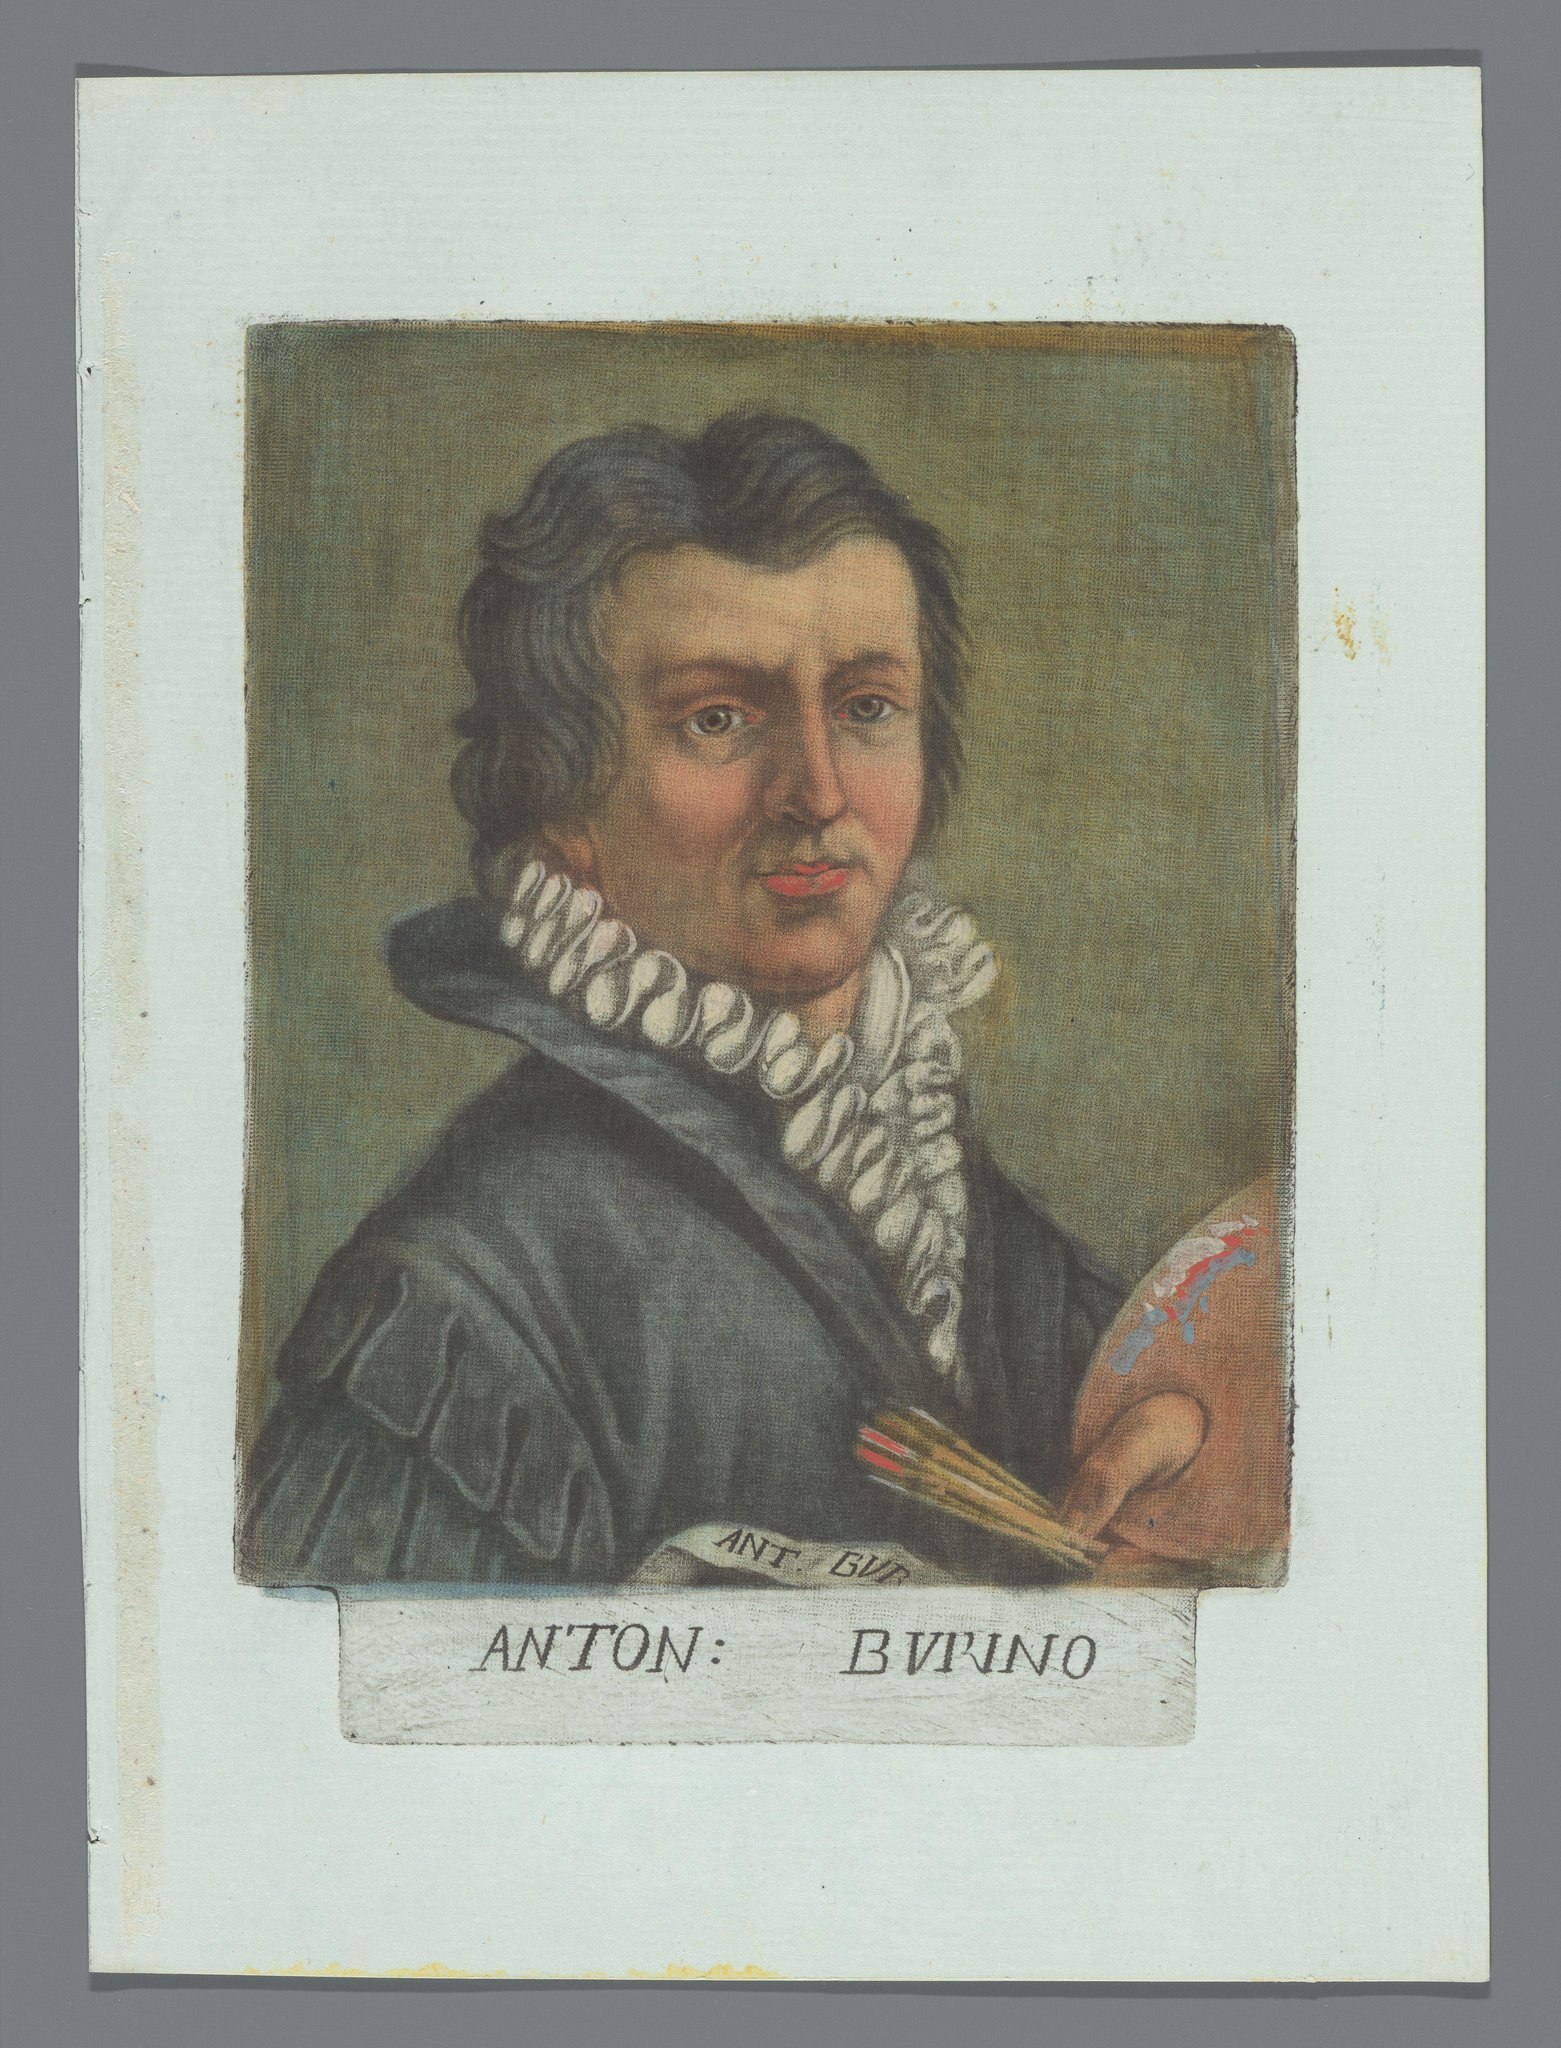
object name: print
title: Gli Autoritratti della Real Galleria di Firenze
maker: carlo lasinio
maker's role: painter, print maker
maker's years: 1759-1838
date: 1789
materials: gouache, paper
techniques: color mezzotint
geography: florence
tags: draughtsman, gian antonio burrini, historical persons, portrait, self-portrait of painter, portrait, self-portrait of artist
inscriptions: inscription:, collector's mark: Lugt 2228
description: Een prent uit een groep van veertig kleurendrukken met kunstenaarsportretten, gebaseerd op de collectie geschilderde zelfportretten van kunstenaars verzameld door de Medici in Florence. De groep maakt deel uit van het grote werk van Lasinio ‘Gli Autoritratti della Real Galleria di Firenze’, uitgegeven in 1789 met omstreeks 350 kunstenaarsportretten. Van deze uitgave is tot nog toe is geen compleet exemplaar bekend. In de inspringende marges onderaan de prenten zijn de namen van de kunstenaars aangebracht en soms hun levensdata en de plaats van geboorte en sterven en een enkele maal de signatuur van Lasinio en dat van de drukker Labrelis. Getuige de bindgaatjes en lijmresten moeten de prenten ingebonden zijn geweest in een album. De meeste prenten zijn verso voorzien van nummers in potlood, met als laagste nummer 2 en hoogste 93. Tevens zijn er verso Italiaanse opschriften in pen aangebracht met de levensdata van de kunstenaars en de school waartoe zij worden gerekend. Deze opschriften zijn vrijwel alle deels afgesneden. Elf prenten zijn niet genummerd en niet voorzien van opschriften. Deze laatste elf zijn alle gedrukt op blauw papier.